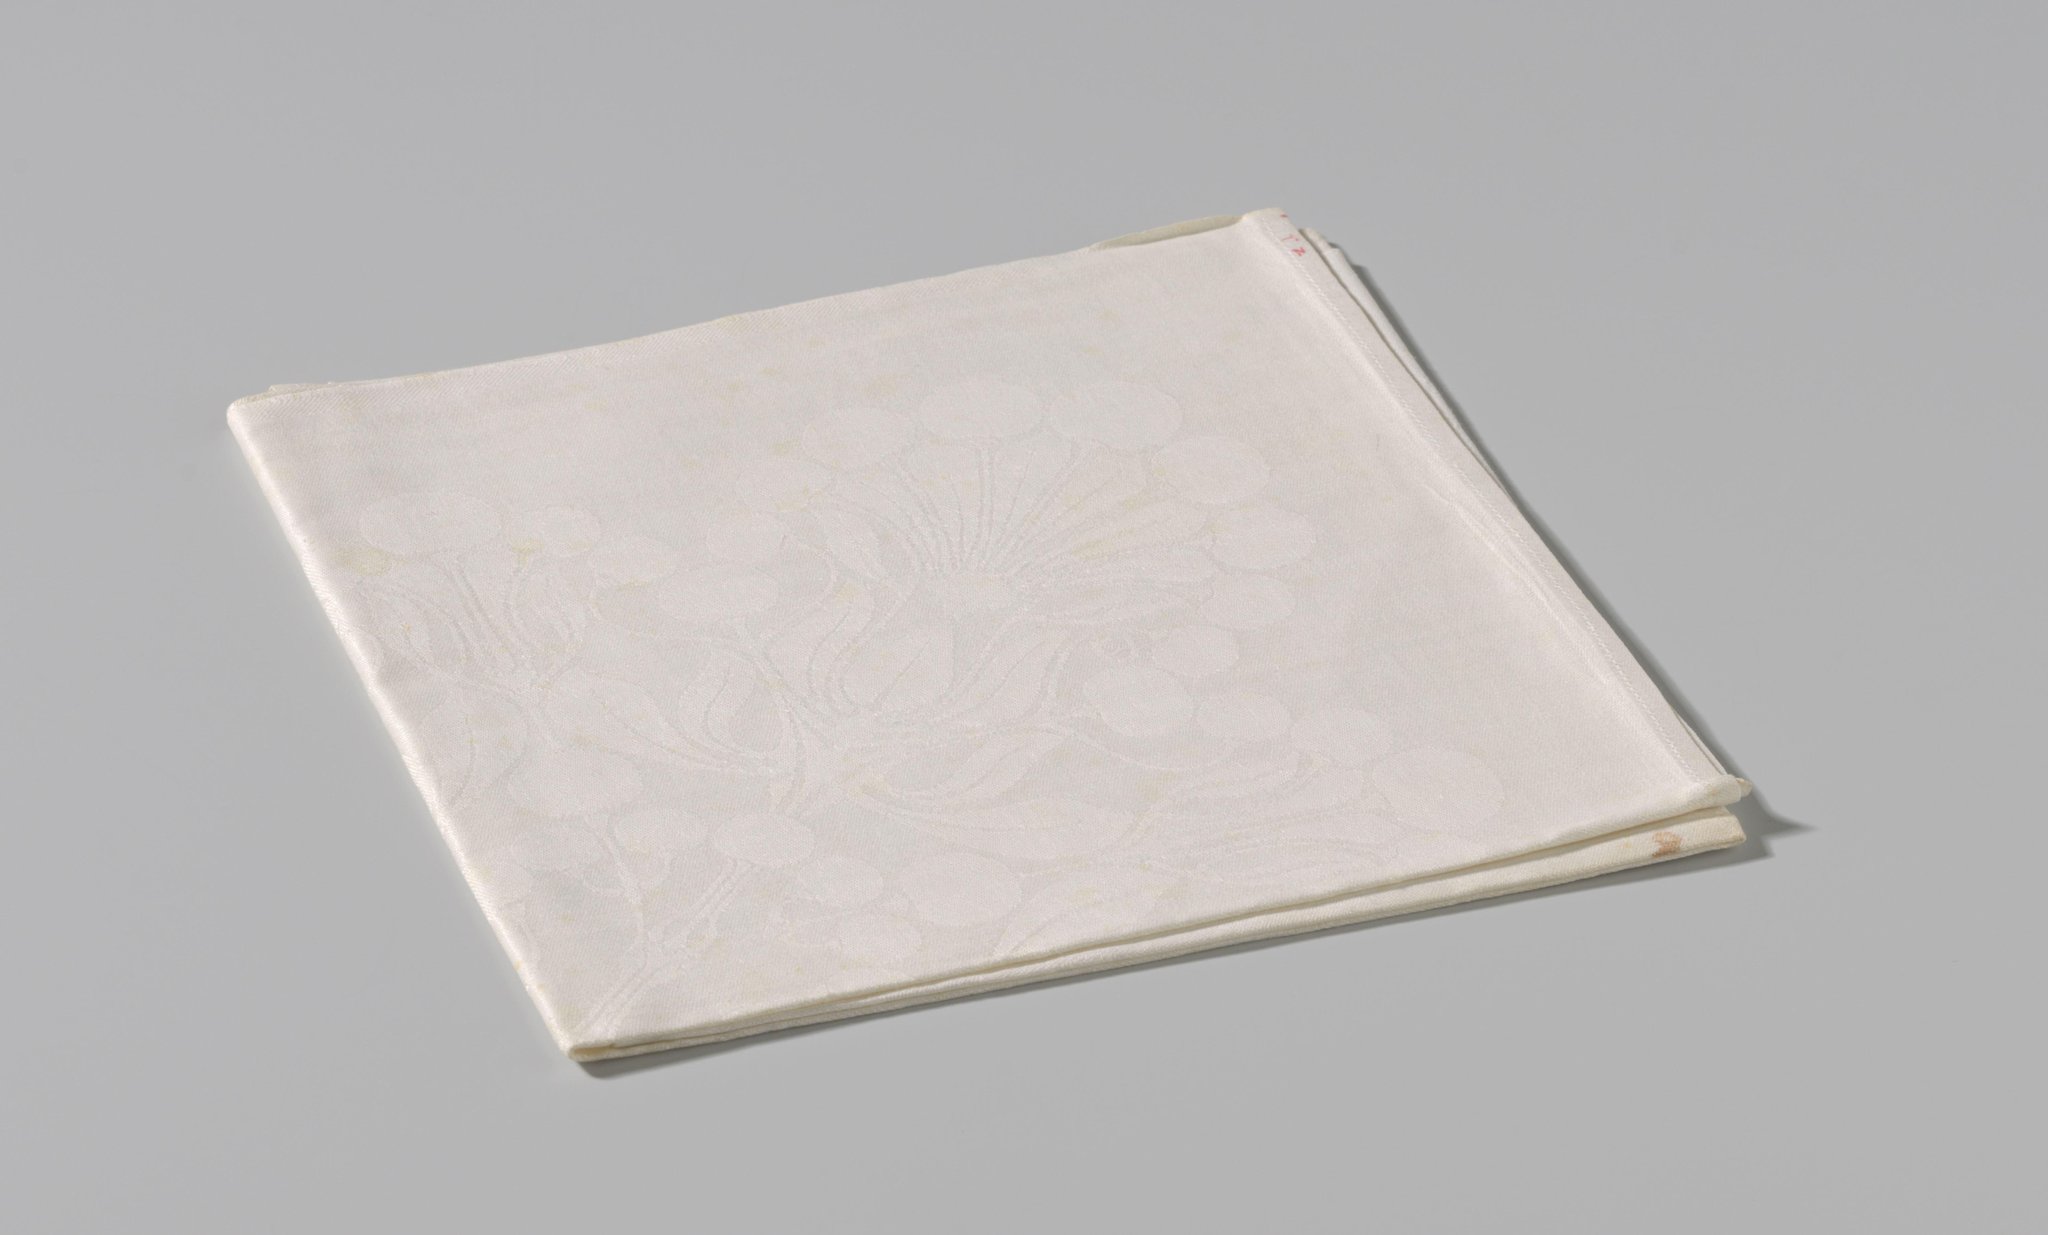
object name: napkin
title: Servet van linnendamast met kersen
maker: chris lebeau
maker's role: draughtsman, print maker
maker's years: 1878-1945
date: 1900-1925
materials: linen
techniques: damask, weave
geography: eindhoven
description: Servet van linnendamast met kersen (dessin 600 van Chris Lebeau). Het servet hoort bij vijf servetten (BK-1971-62-A t/m BK-1971-62-F) en een tafellaken (BK-1971-61).